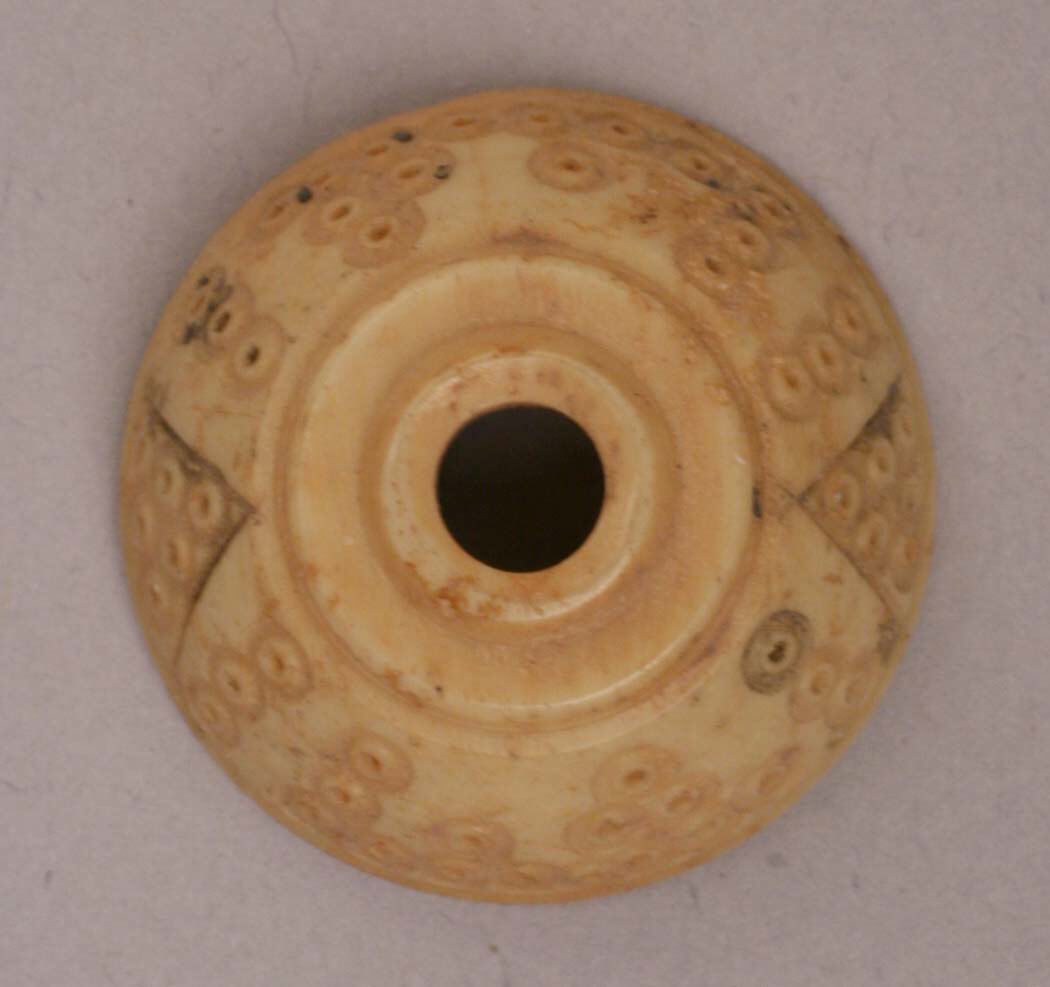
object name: button or bead or spindle whorl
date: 801-1000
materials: bone, paint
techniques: incising, inlay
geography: iran